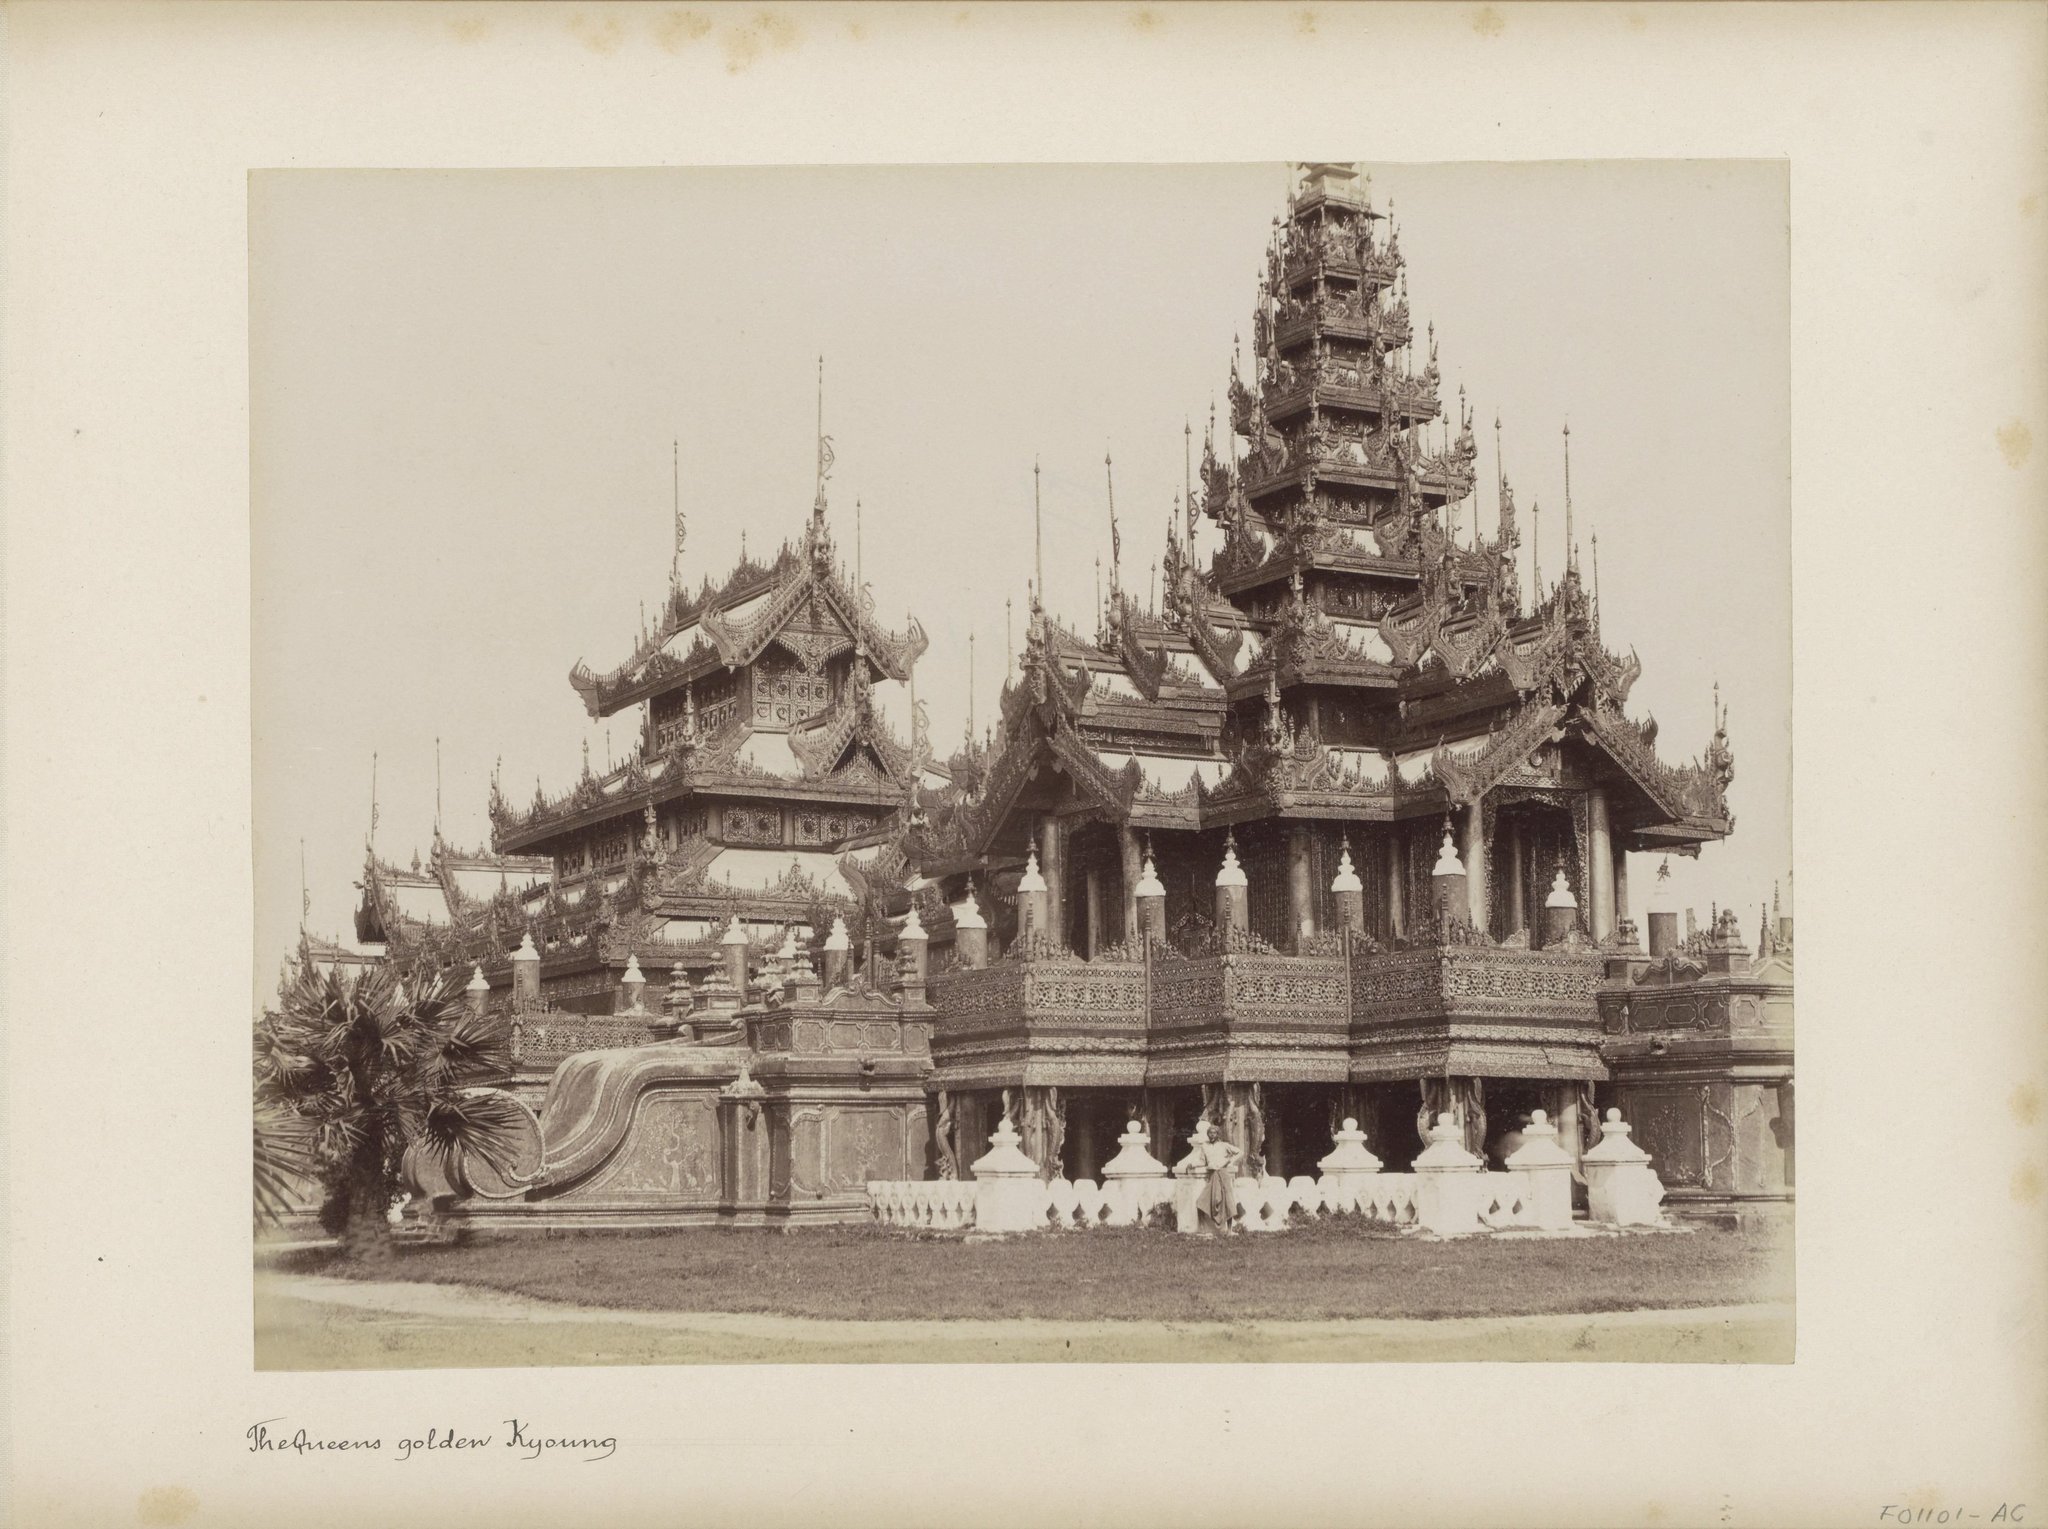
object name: photograph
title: Exterior of the Golden Monastery of the Burmese queen Supayalat in Mandalay, Myanmar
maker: Anonymous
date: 1885-1886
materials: cardboard, paper, photographic support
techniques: albumen print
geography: mandalay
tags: temple, shrine ~ hinduism, buddhism, jainism, palace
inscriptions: caption: ‘The Queens golden Kyoung’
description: Onderdeel van Reisalbum met foto's van bezienswaardigheden in Birma.